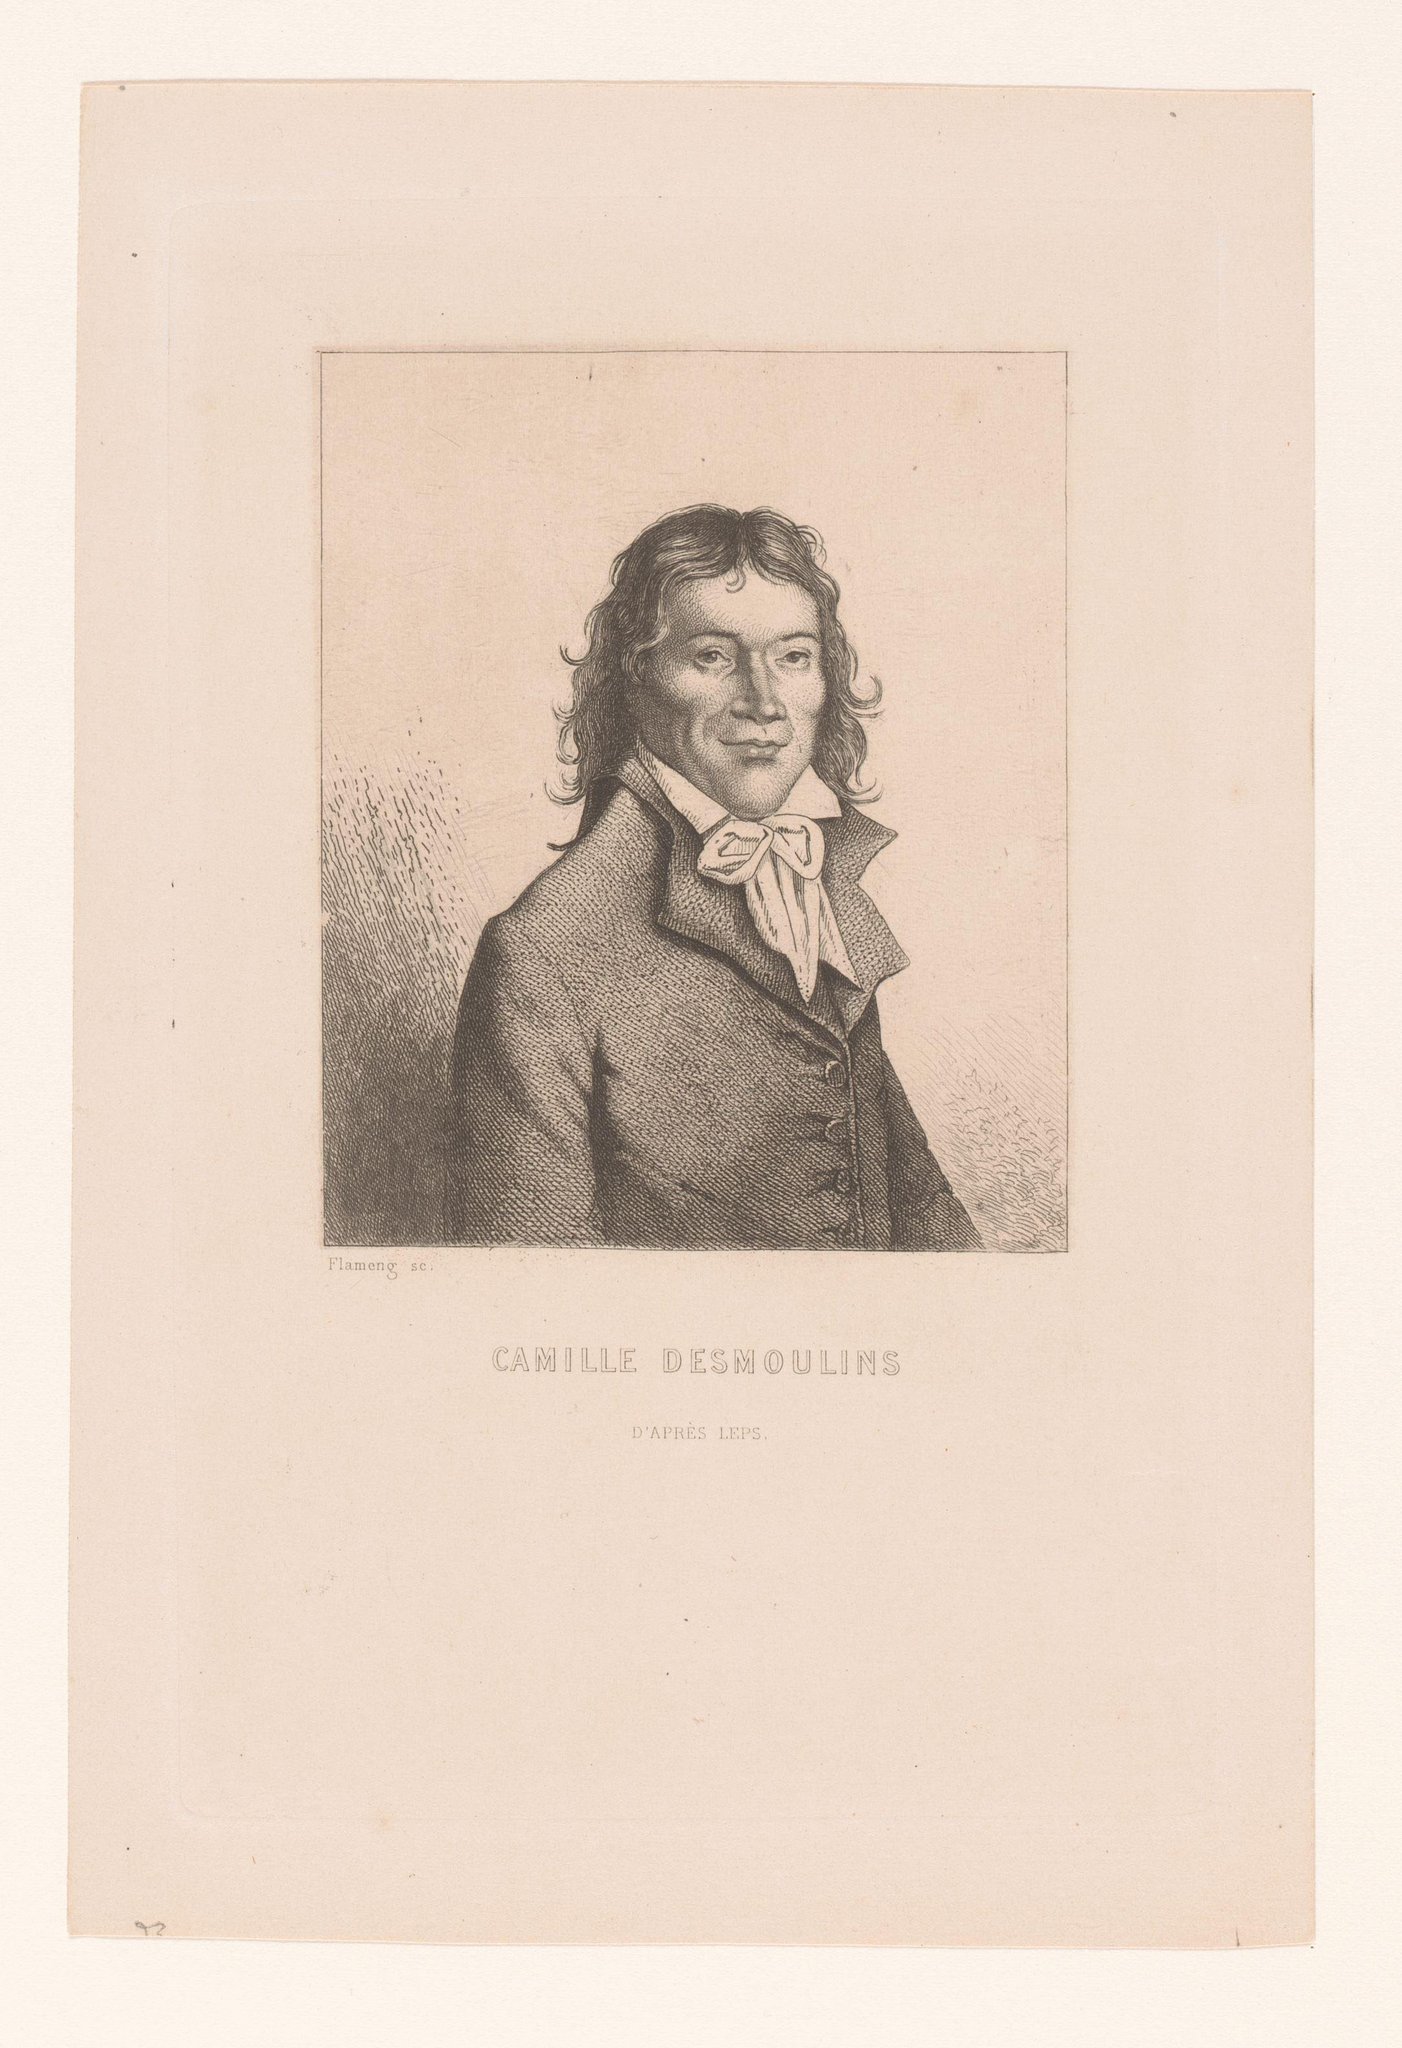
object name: print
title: Portret van Camille Desmoulins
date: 1841-1910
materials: paper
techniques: etching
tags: paris, politician, historical persons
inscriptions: collector's mark: Lugt 2228